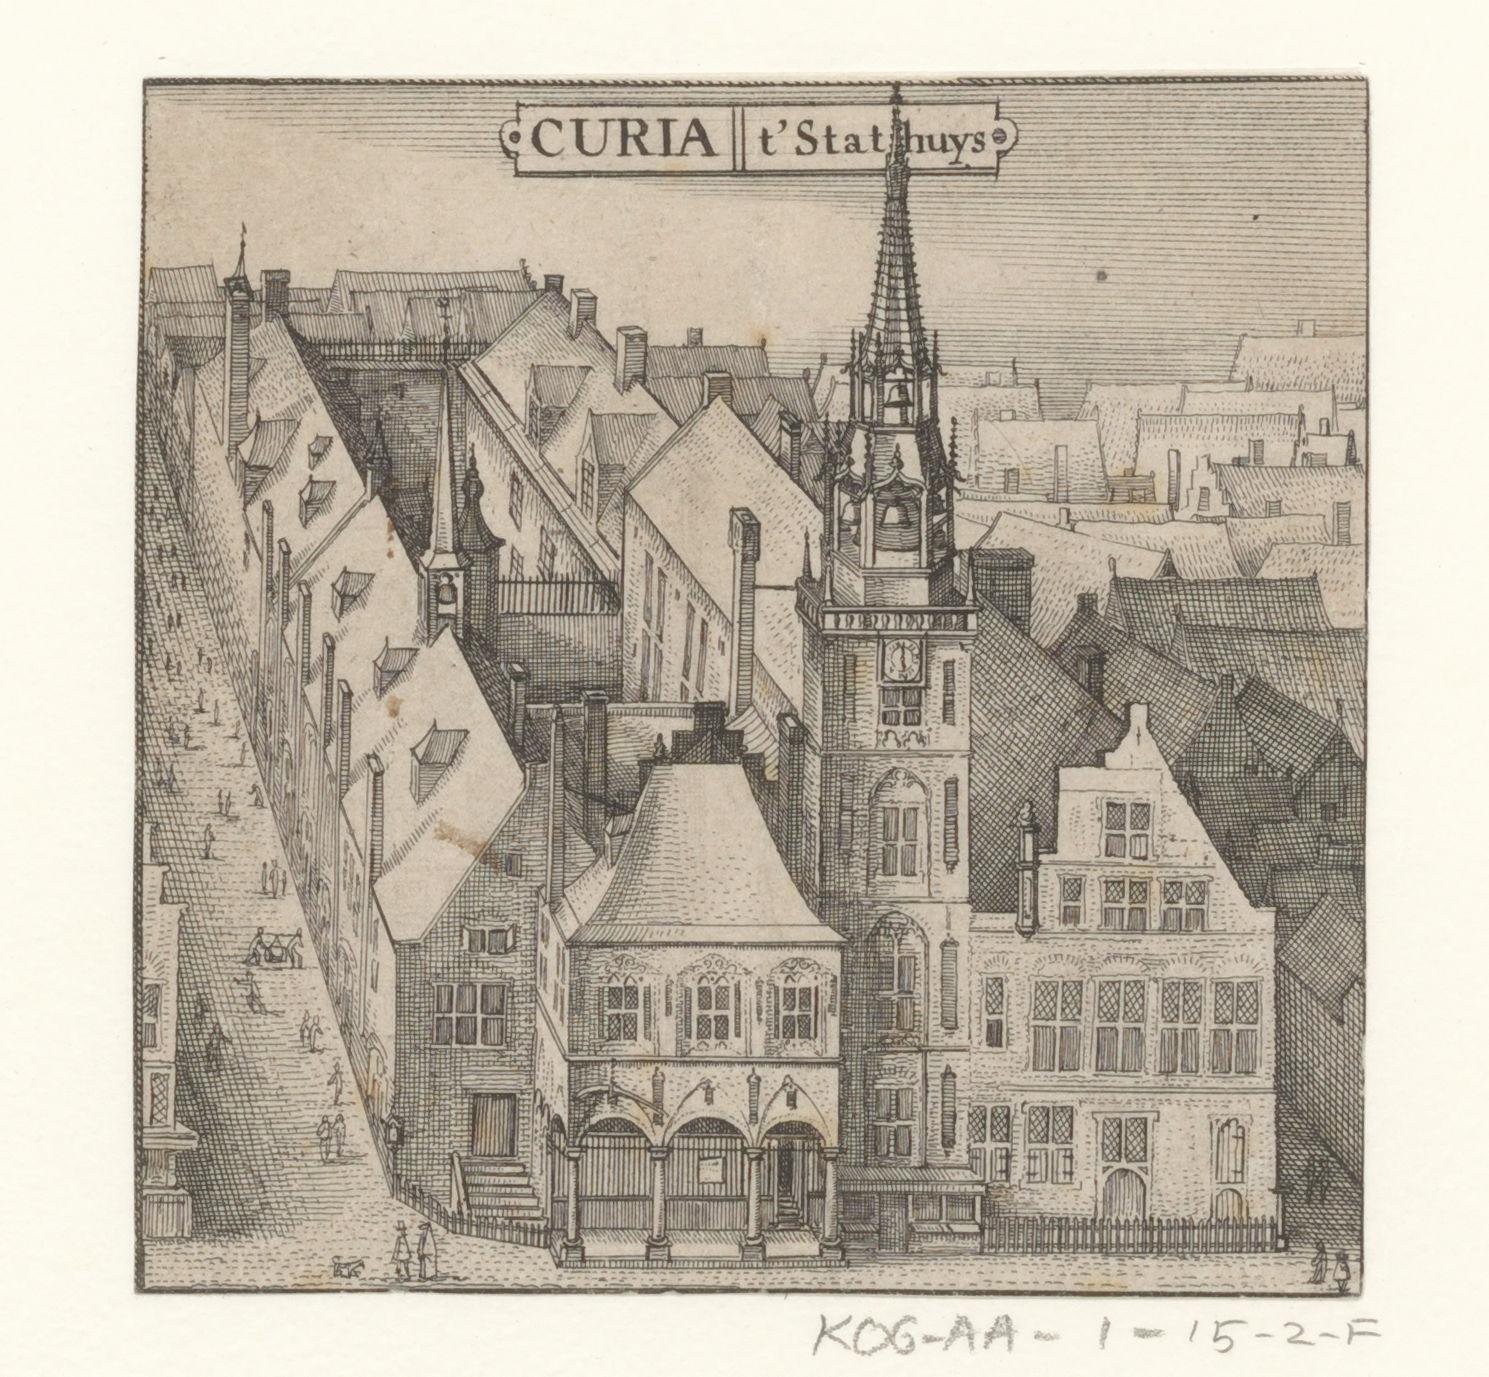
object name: print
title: Gezicht op het oude stadhuis van Amsterdam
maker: Anonymous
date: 1700-1799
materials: paper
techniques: etching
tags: city-view in general; 'veduta', townhall, street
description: Onderwerpsrubriek binnen de Atlas Amsterdam: Oude Stadhuis, Oude Stadhuis op den Dam: b. met verlaagden torenspits.